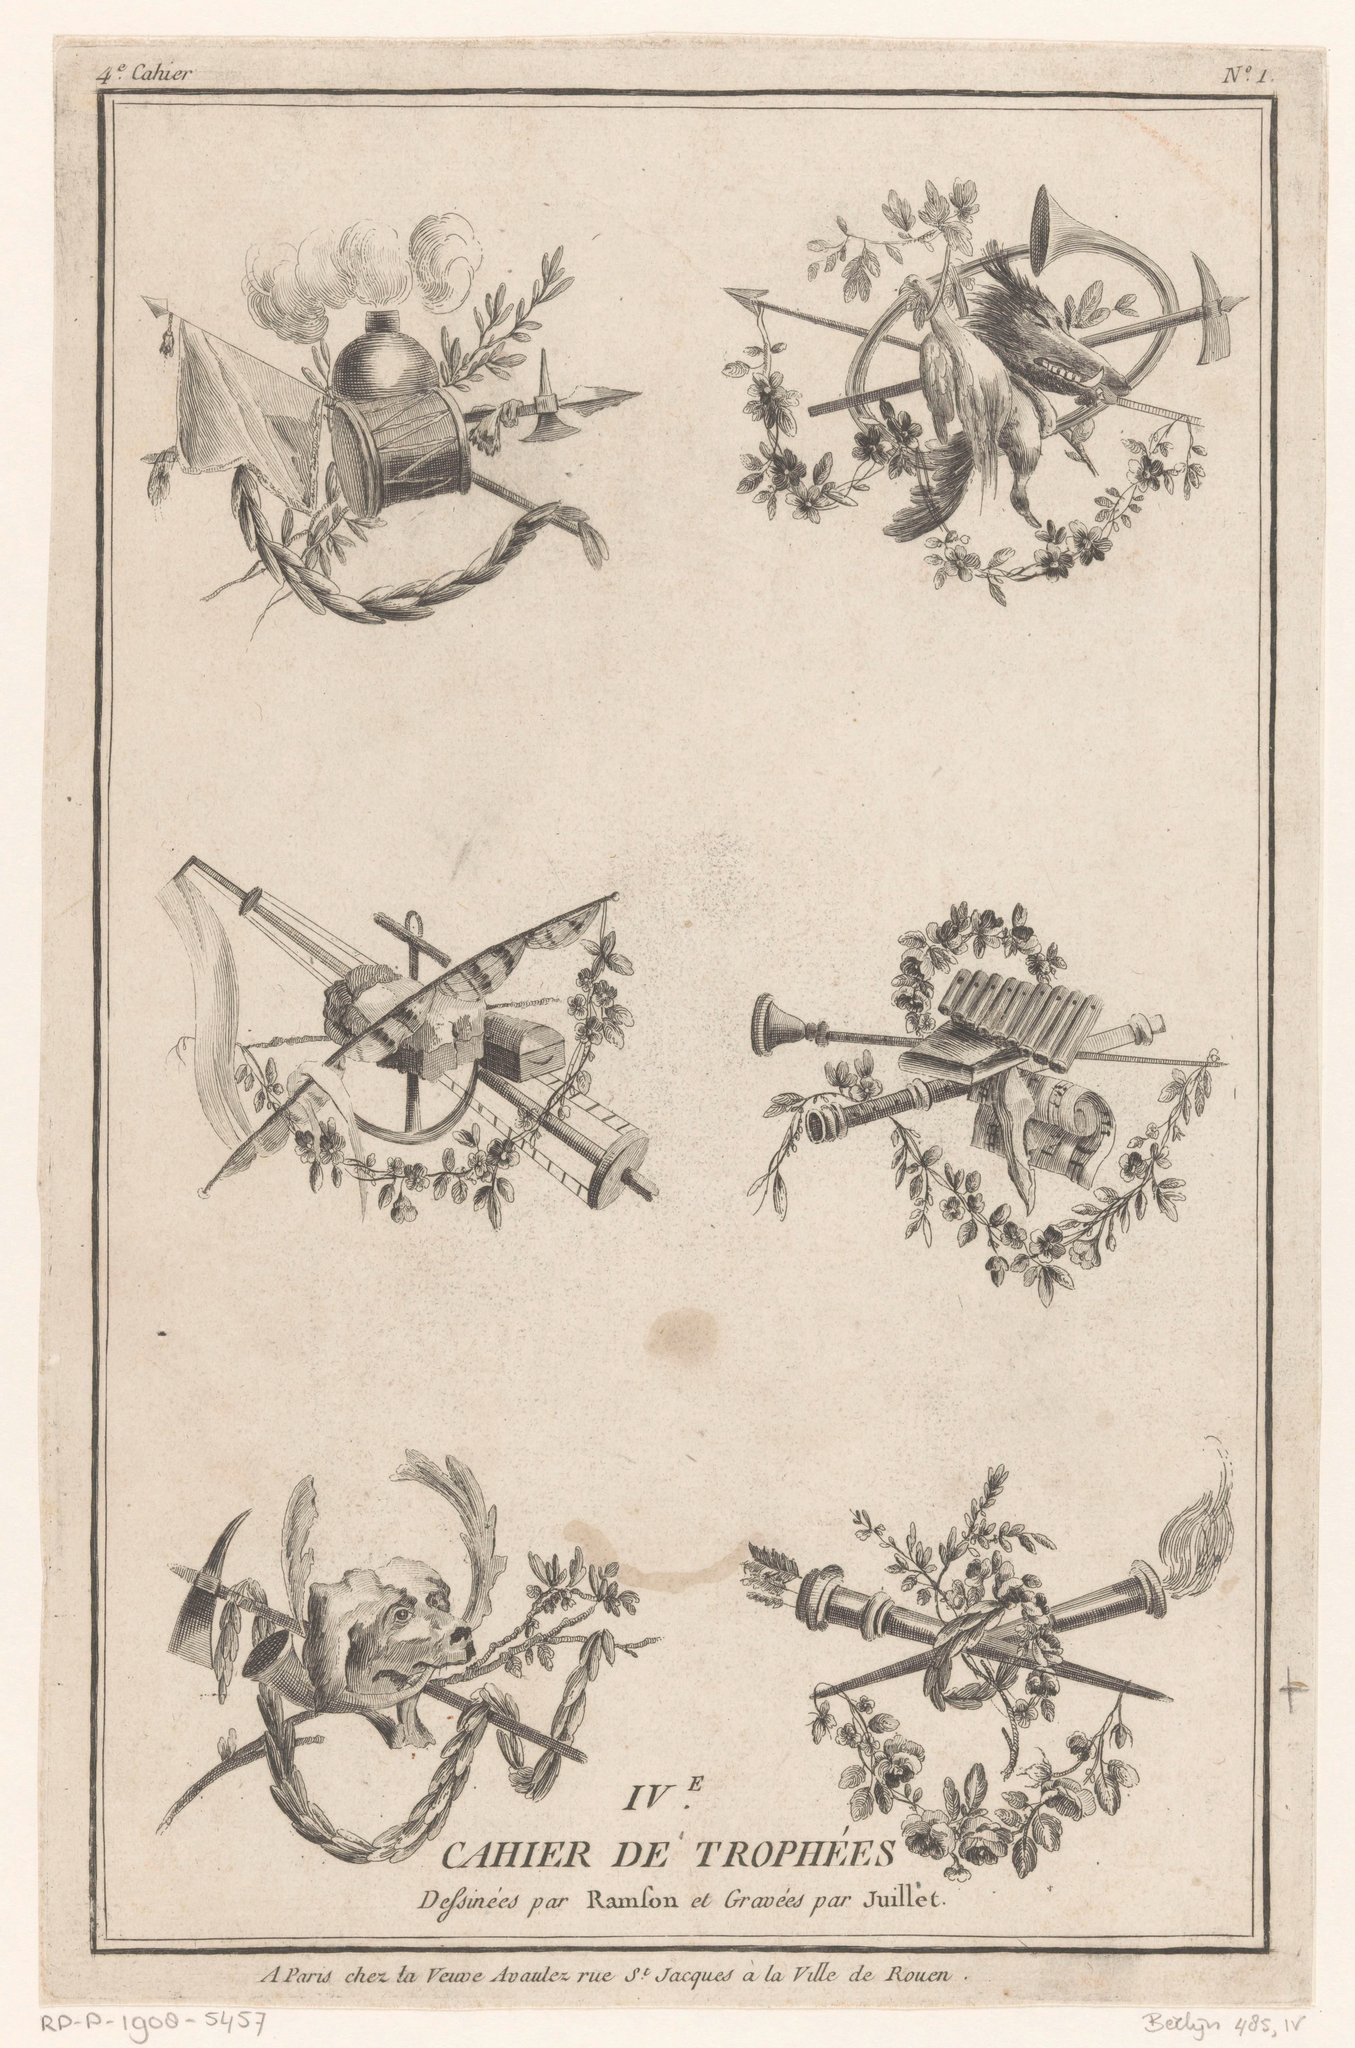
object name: ornament print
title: Trofeeën met wapens, jachtattributen en muziekinstrumenten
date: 1777-1779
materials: paper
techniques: etching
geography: paris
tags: musical instruments; group of musical instruments, trophy, i.e.: decorative arrangement of symbolic or typical objects ~ ornament, hunting, chase, weapons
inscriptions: collector's mark: Lugt 2228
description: Zes trofeeën met diverse attributen zoals wapens, een jachthoorn en wild, een anker en een mast, muziekinstrumenten en een fakkel en pijlenkoker.